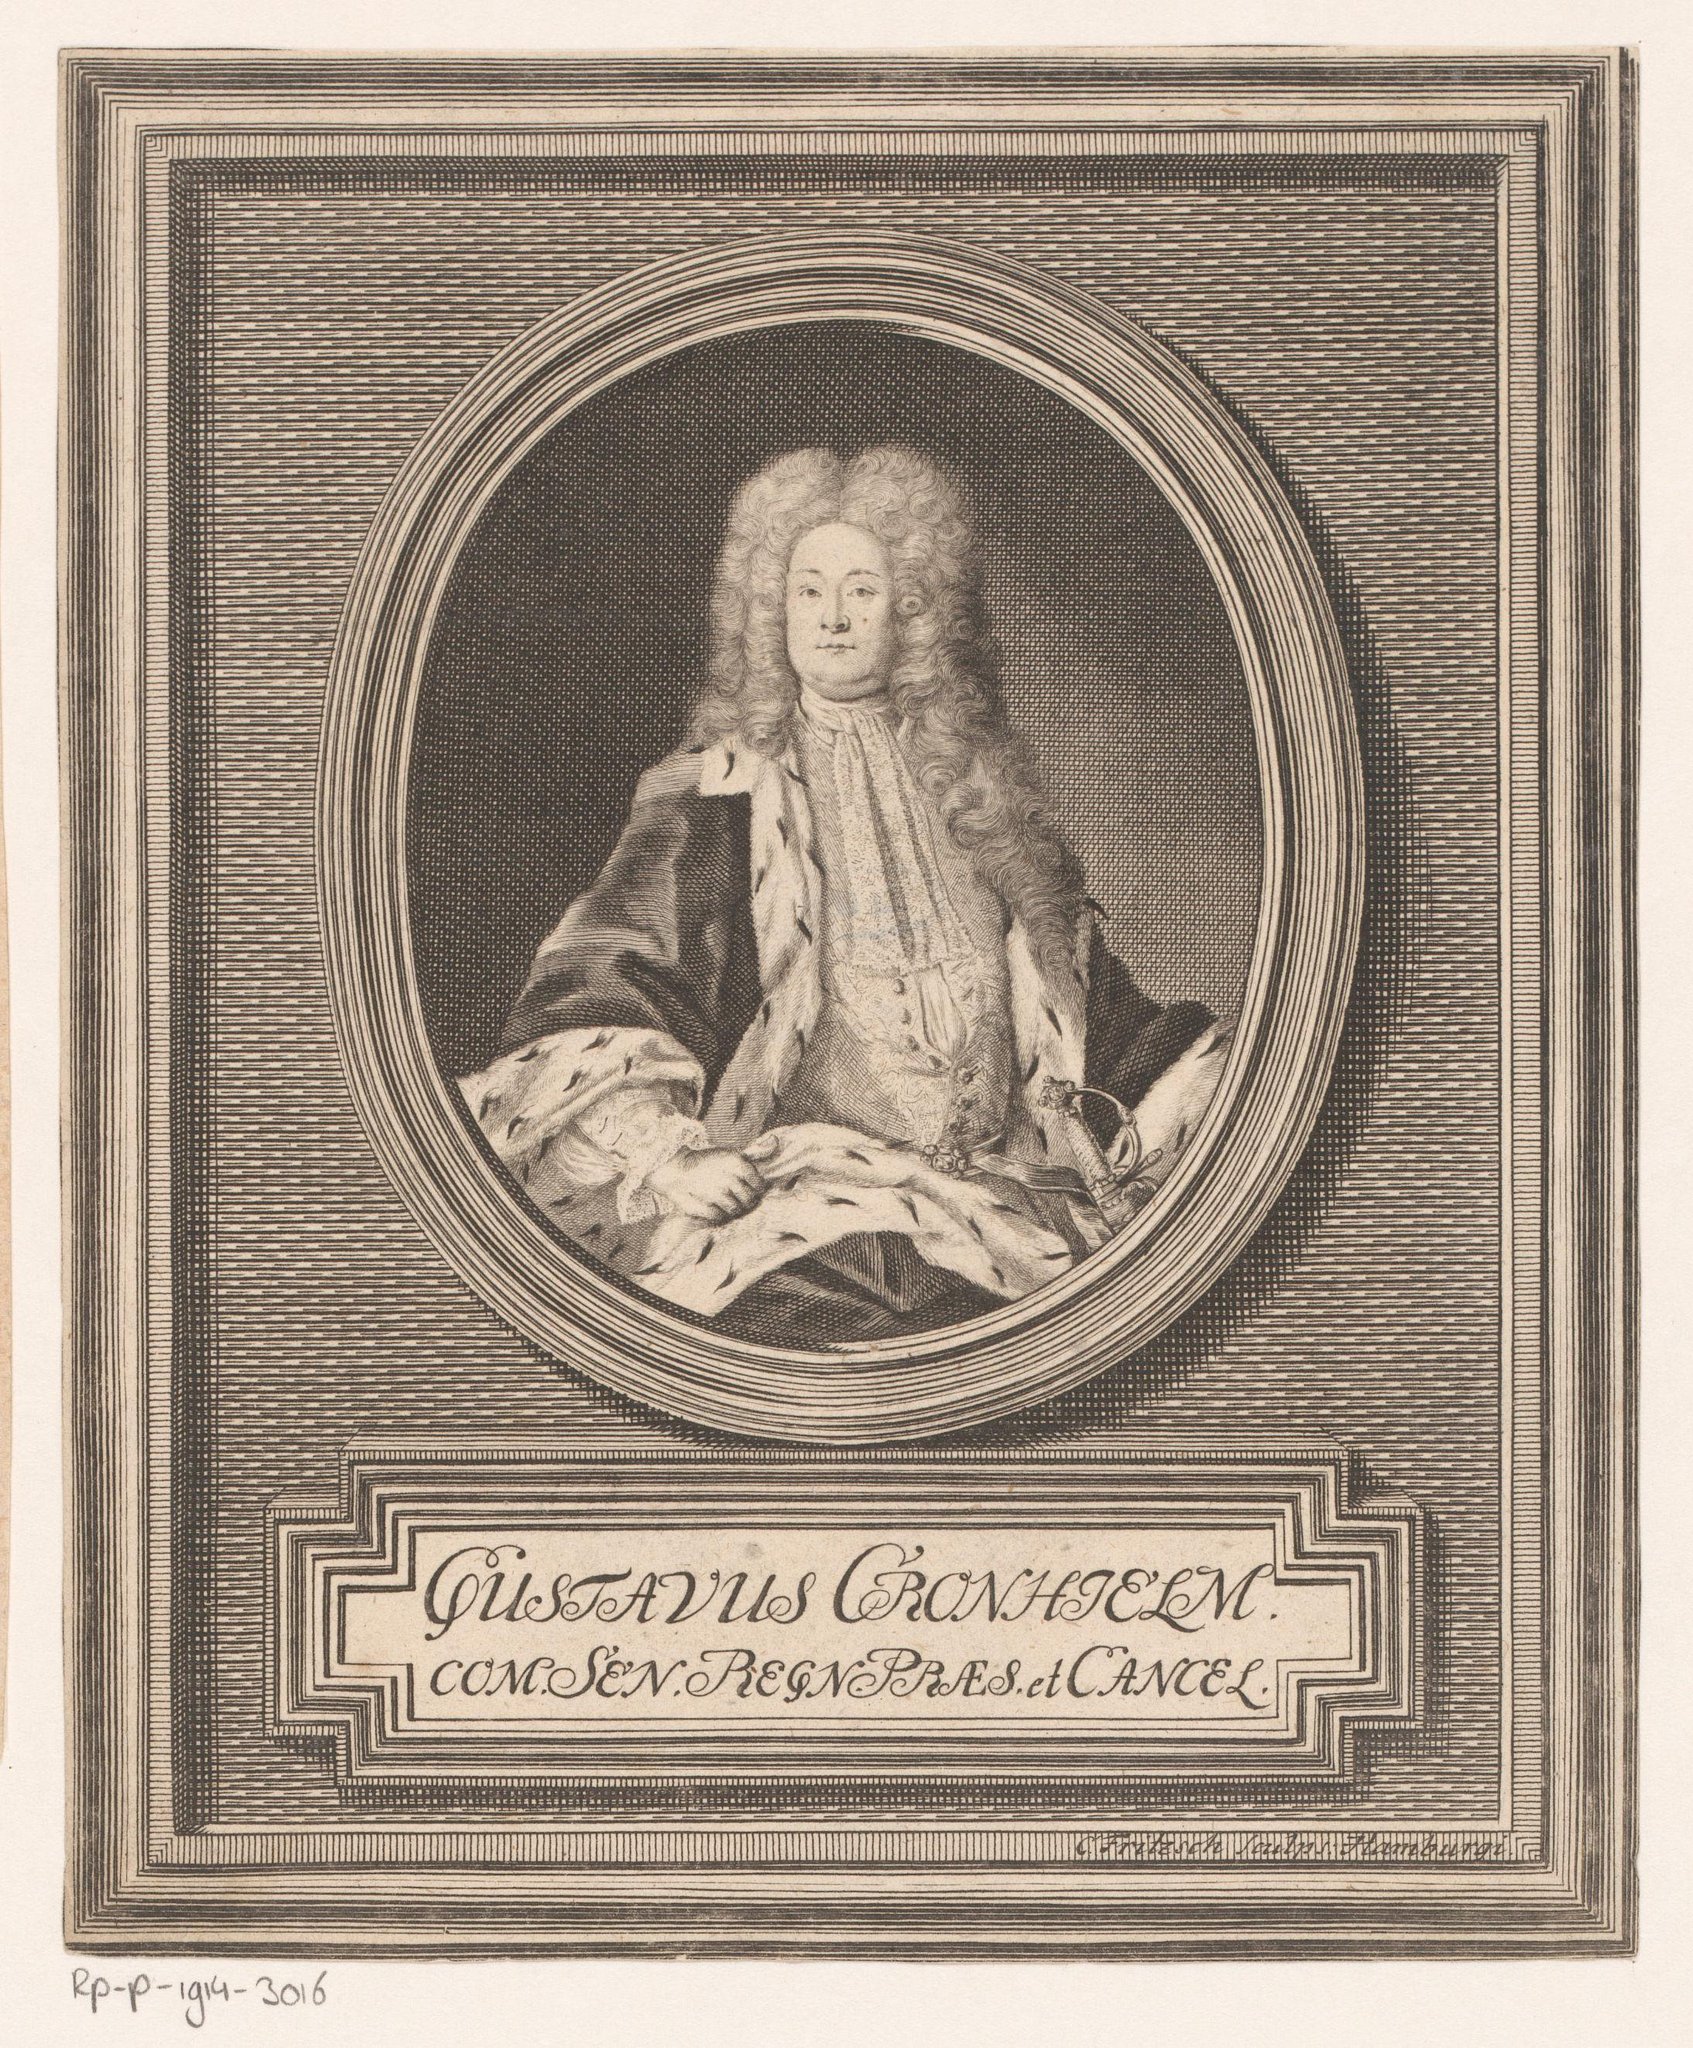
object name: print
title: Portret van Gustaf Cronhielm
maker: christian fritzsch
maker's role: print maker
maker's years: 1695-1769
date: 1705-1737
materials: paper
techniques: engraving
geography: hamburg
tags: historical persons, hacking and thrusting weapons: sword, mantle, gown, dress (symbol of sovereignty)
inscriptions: collector's mark: Lugt 2228